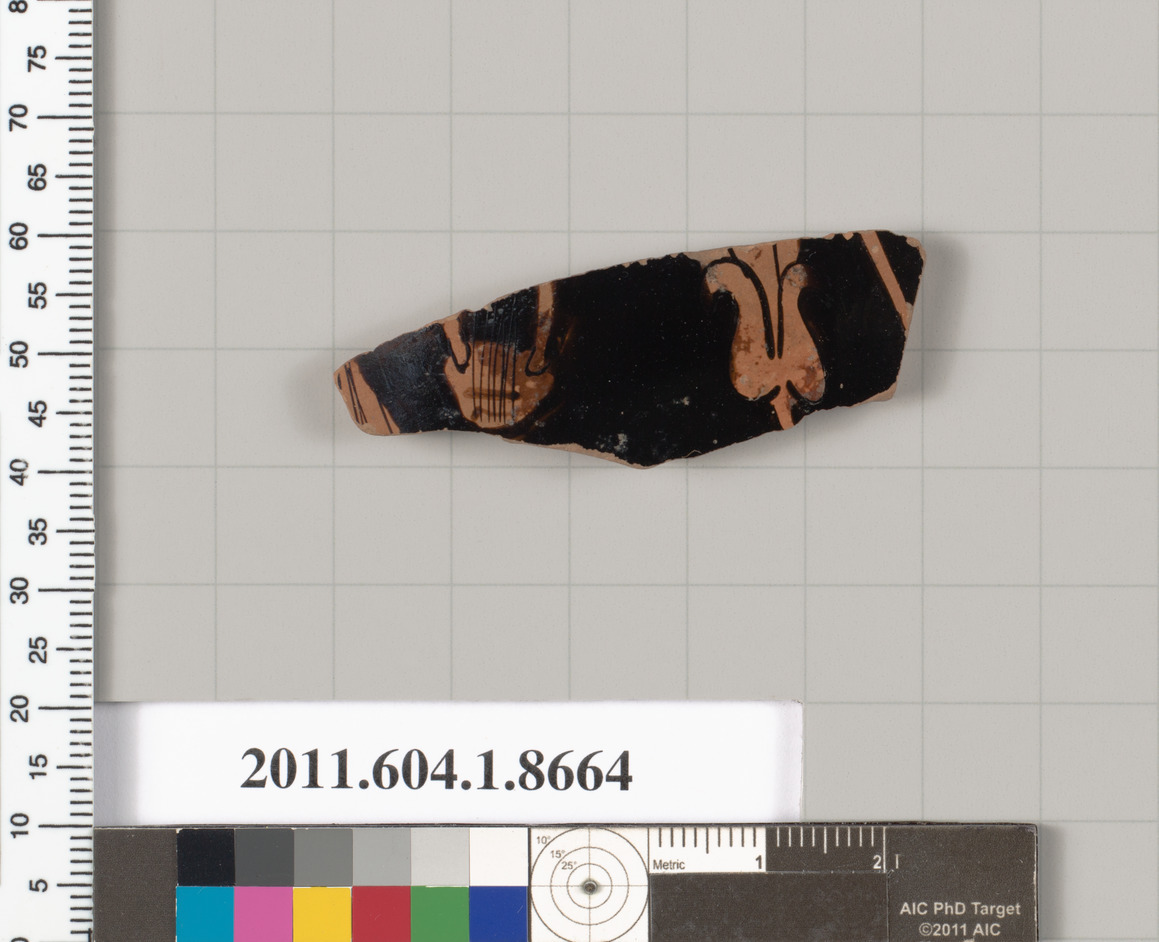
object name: kylix fragment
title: Terracotta rim fragment of a stemless? kylix (drinking cup)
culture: greek, attic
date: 460-450 BCE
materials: terracotta